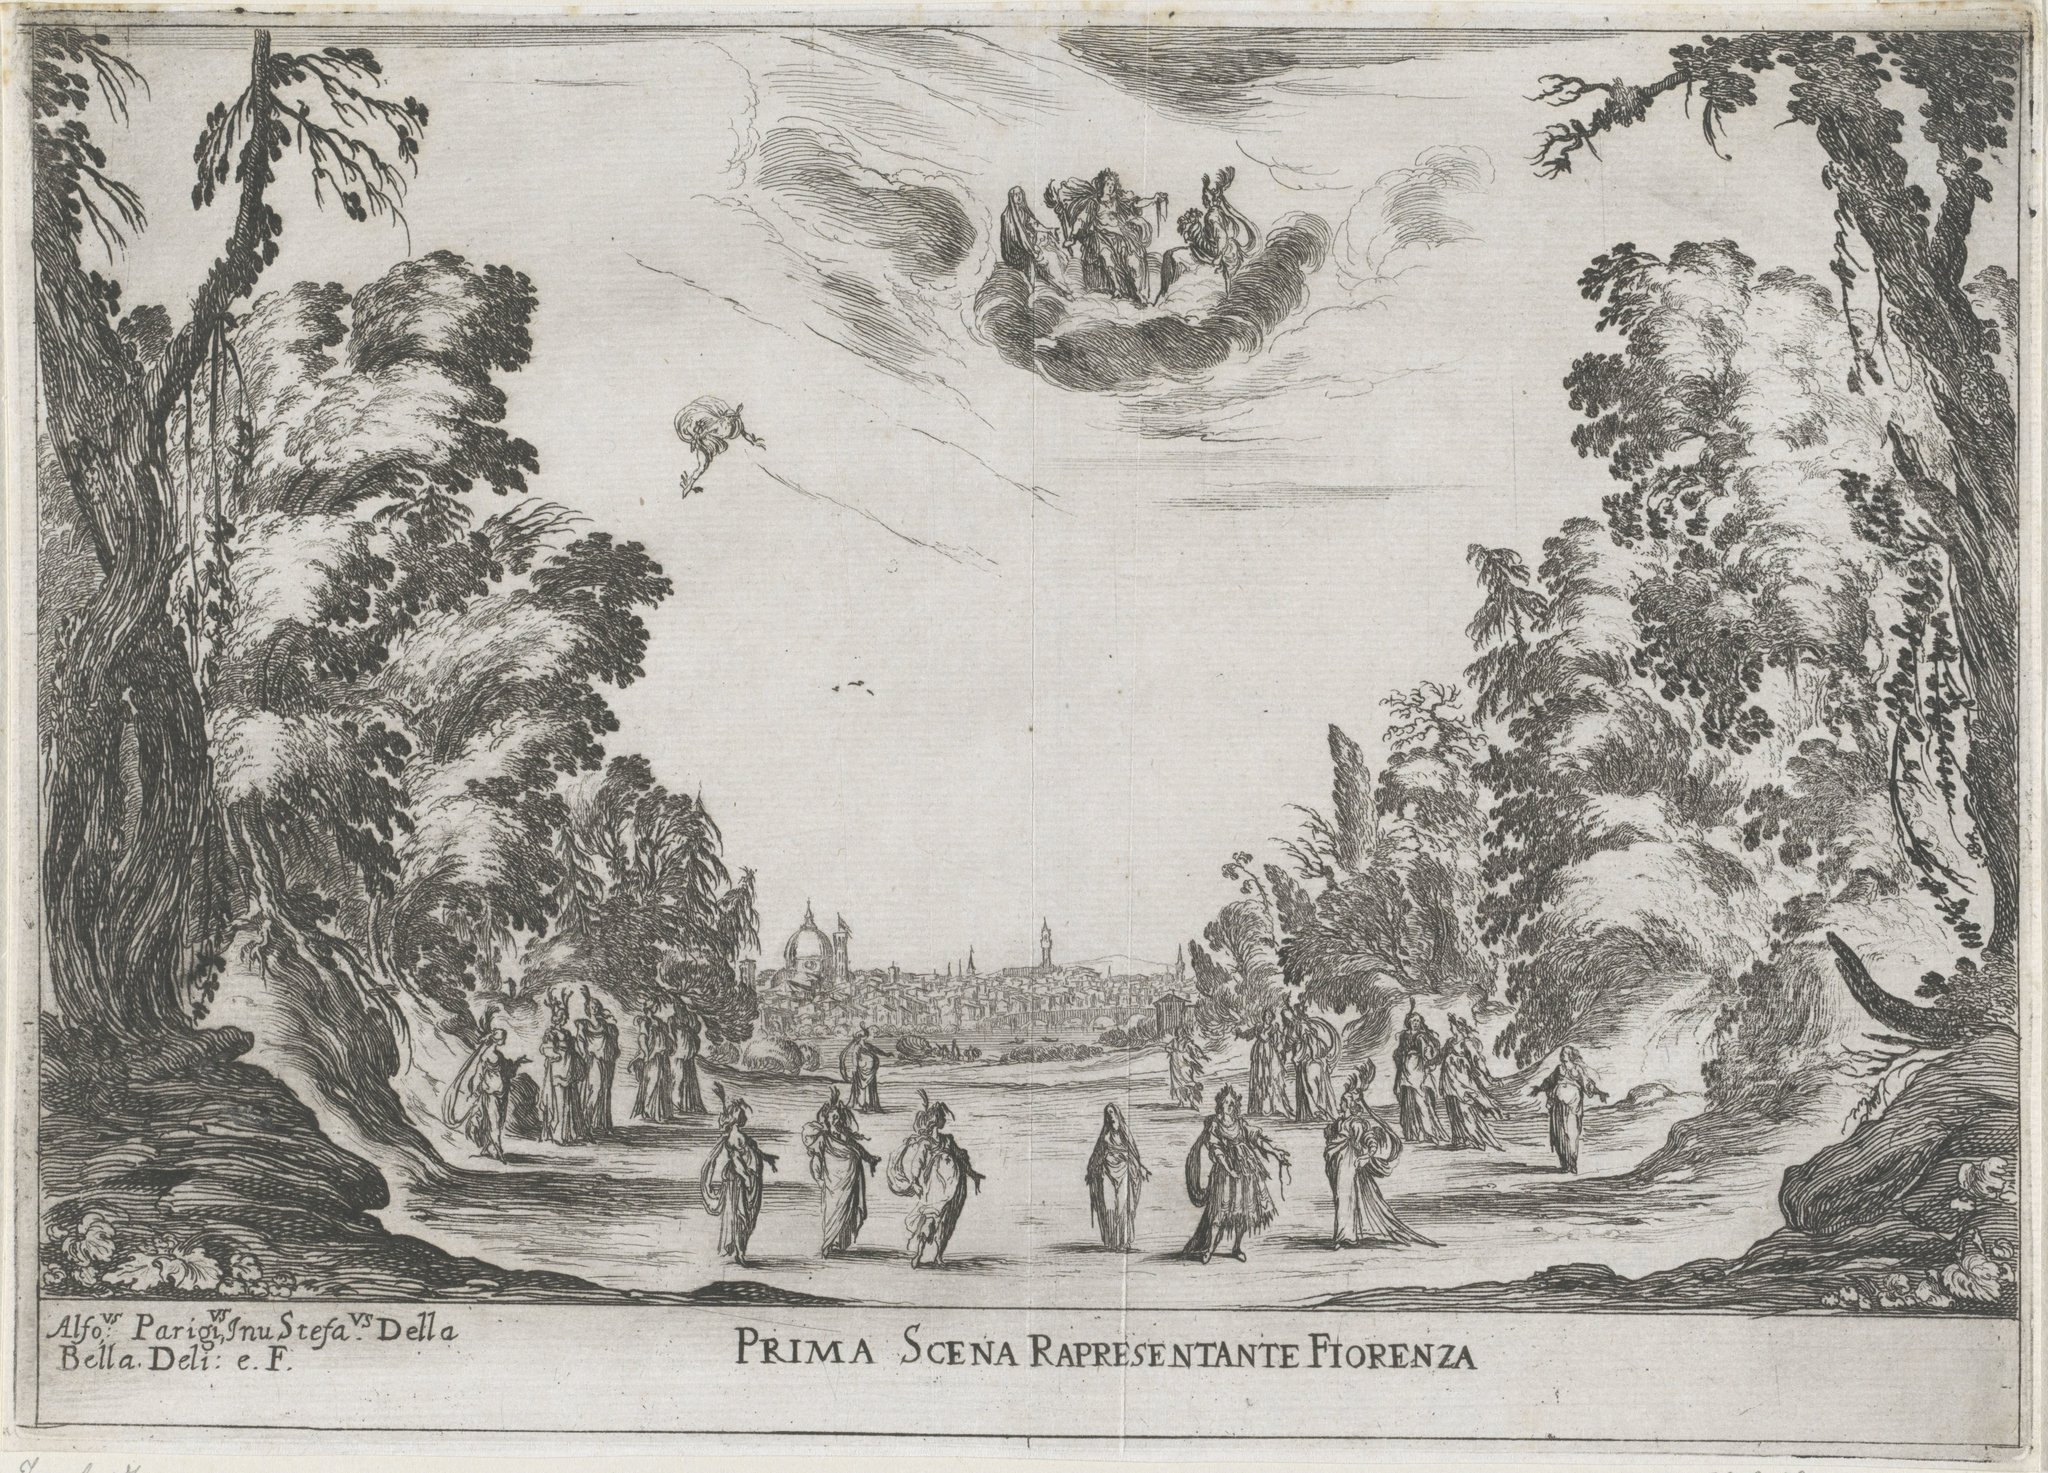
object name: print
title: Eerste scène: Florence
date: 1637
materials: paper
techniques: etching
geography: italy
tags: set, scenery ~ stage, stage costume, the ballet, ballet performance, backdrop, actor (on the stage)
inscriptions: collector's mark: Lugt 240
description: Deze prent maakt deel uit van een reeks prenten met scènes uit het liberetto 'Le Nozze degli Dei Favola...' door Giovanni Carlo Coppola, ter ere van het huwelijk van Ferdinando II de' Medici en Vittoria della Rovere op 8 juli 1637.